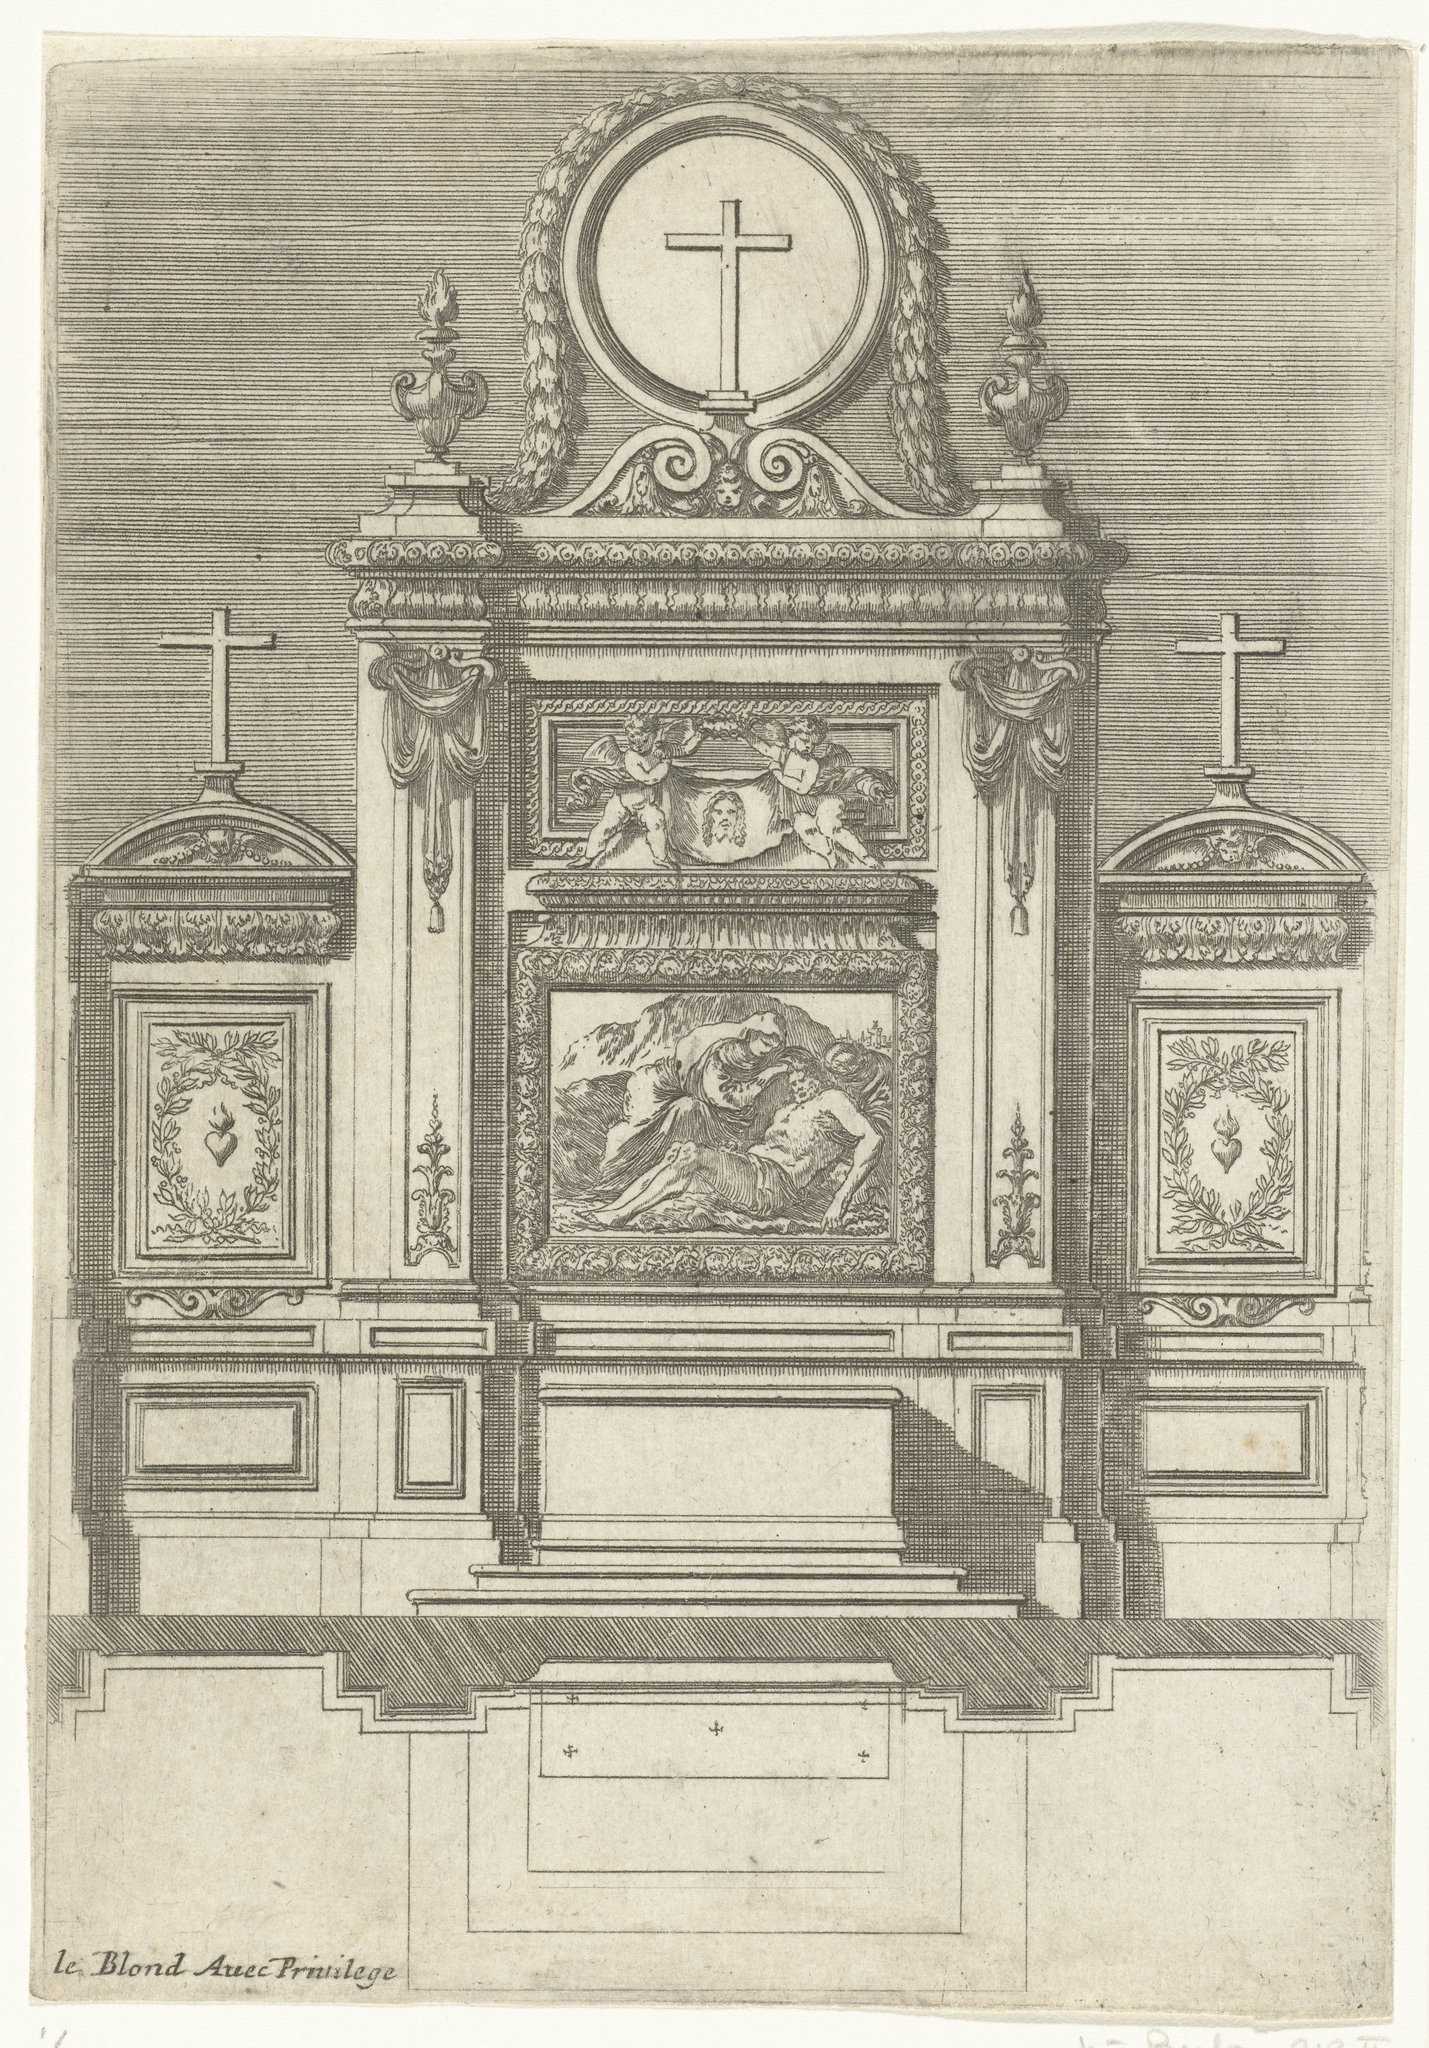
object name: print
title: Altaren met plan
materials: paper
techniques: etching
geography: france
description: In het midden hangt een schilderij met een detail van de Kruisafneming. Met opstand en plan. Uit serie van 6 bladen, eerste editie.